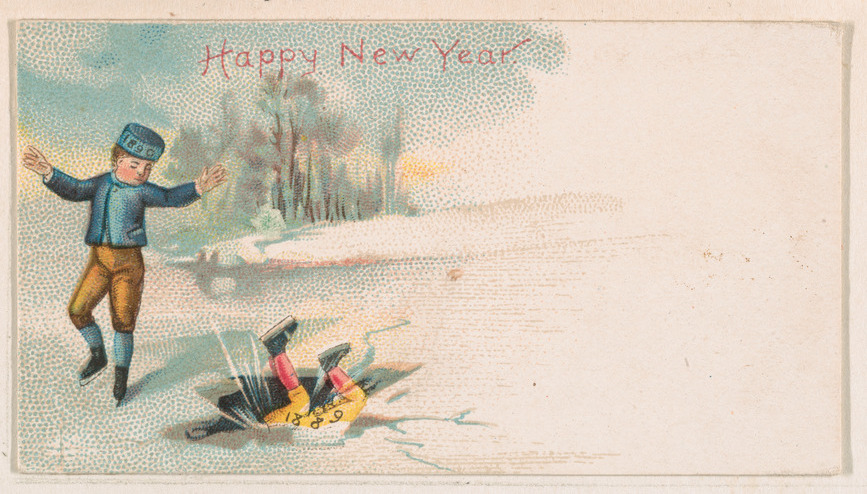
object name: print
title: Happy New Year, from the New Years 1890 series (N227) issued by Kinney Bros.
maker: kinney brothers tobacco company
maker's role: publisher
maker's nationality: american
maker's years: 1869-2011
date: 1889-1890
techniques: color lithograph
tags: boys